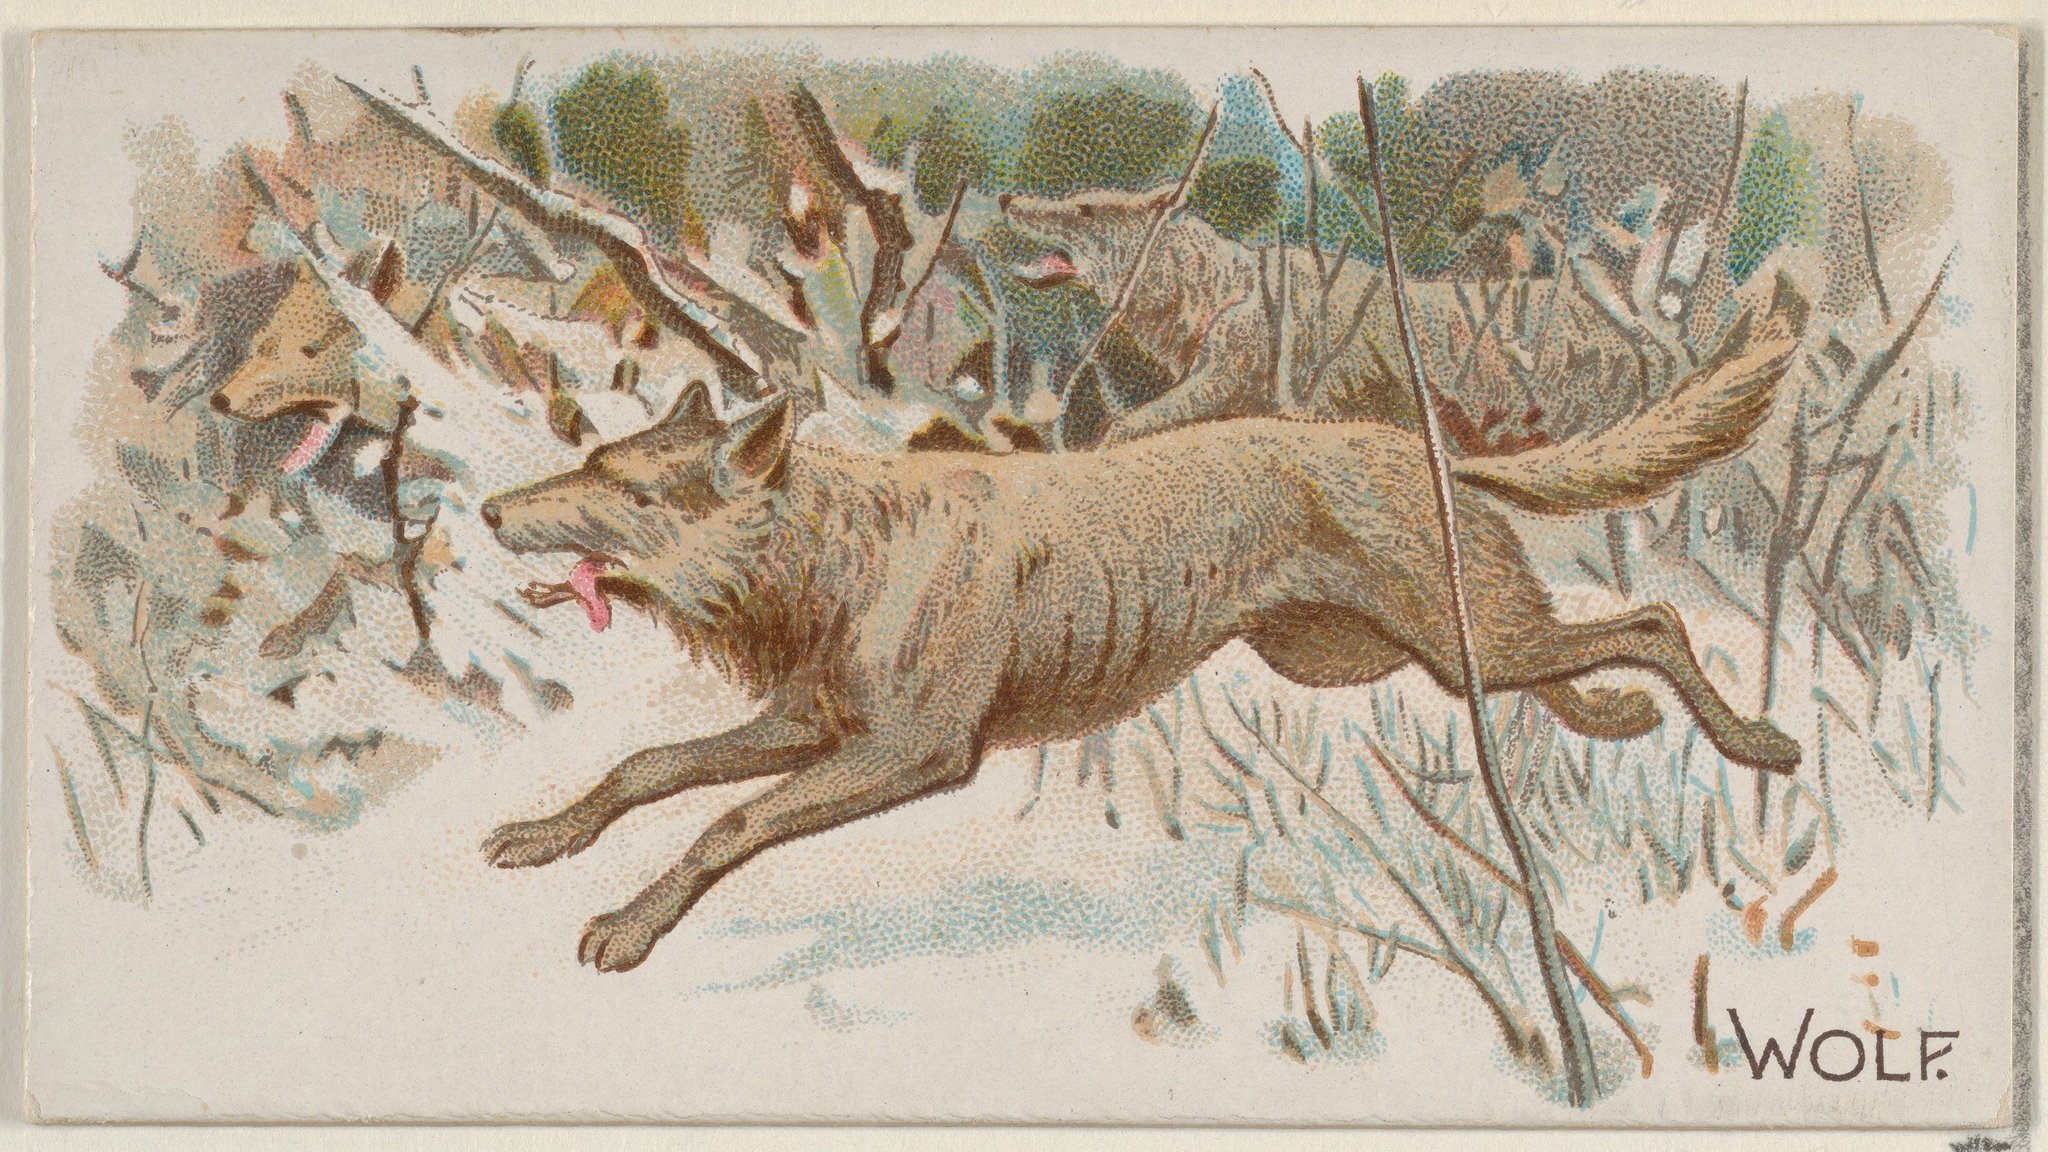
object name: print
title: Wolf, from the Quadrupeds series (N21) for Allen & Ginter Cigarettes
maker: allen & ginter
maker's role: publisher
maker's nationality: american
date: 1890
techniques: color lithograph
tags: wolves